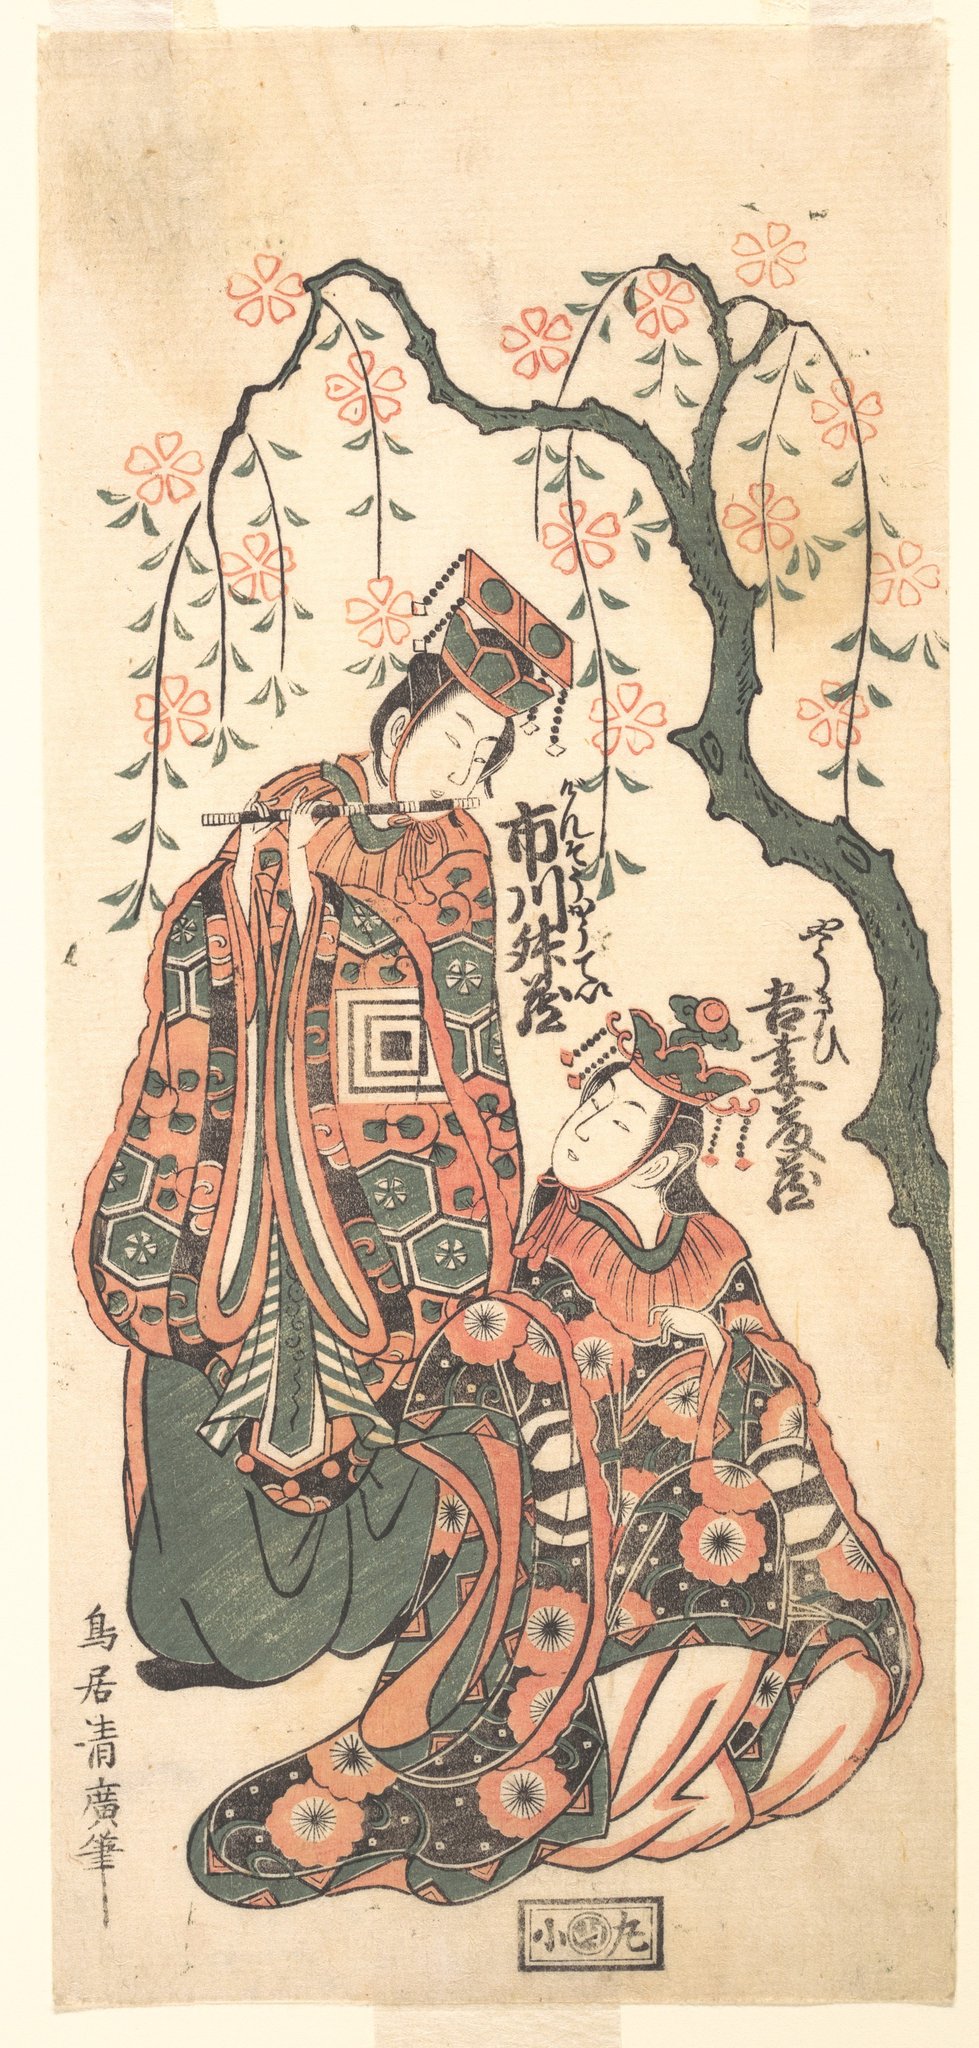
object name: print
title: Scene from the Play "Keisei Kaneni Sakura"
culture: japanese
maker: torii kiyohiro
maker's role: artist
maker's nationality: japanese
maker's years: 1737-1776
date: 1756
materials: ink, paper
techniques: woodblock print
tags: men,women,flutes,flowers,trees